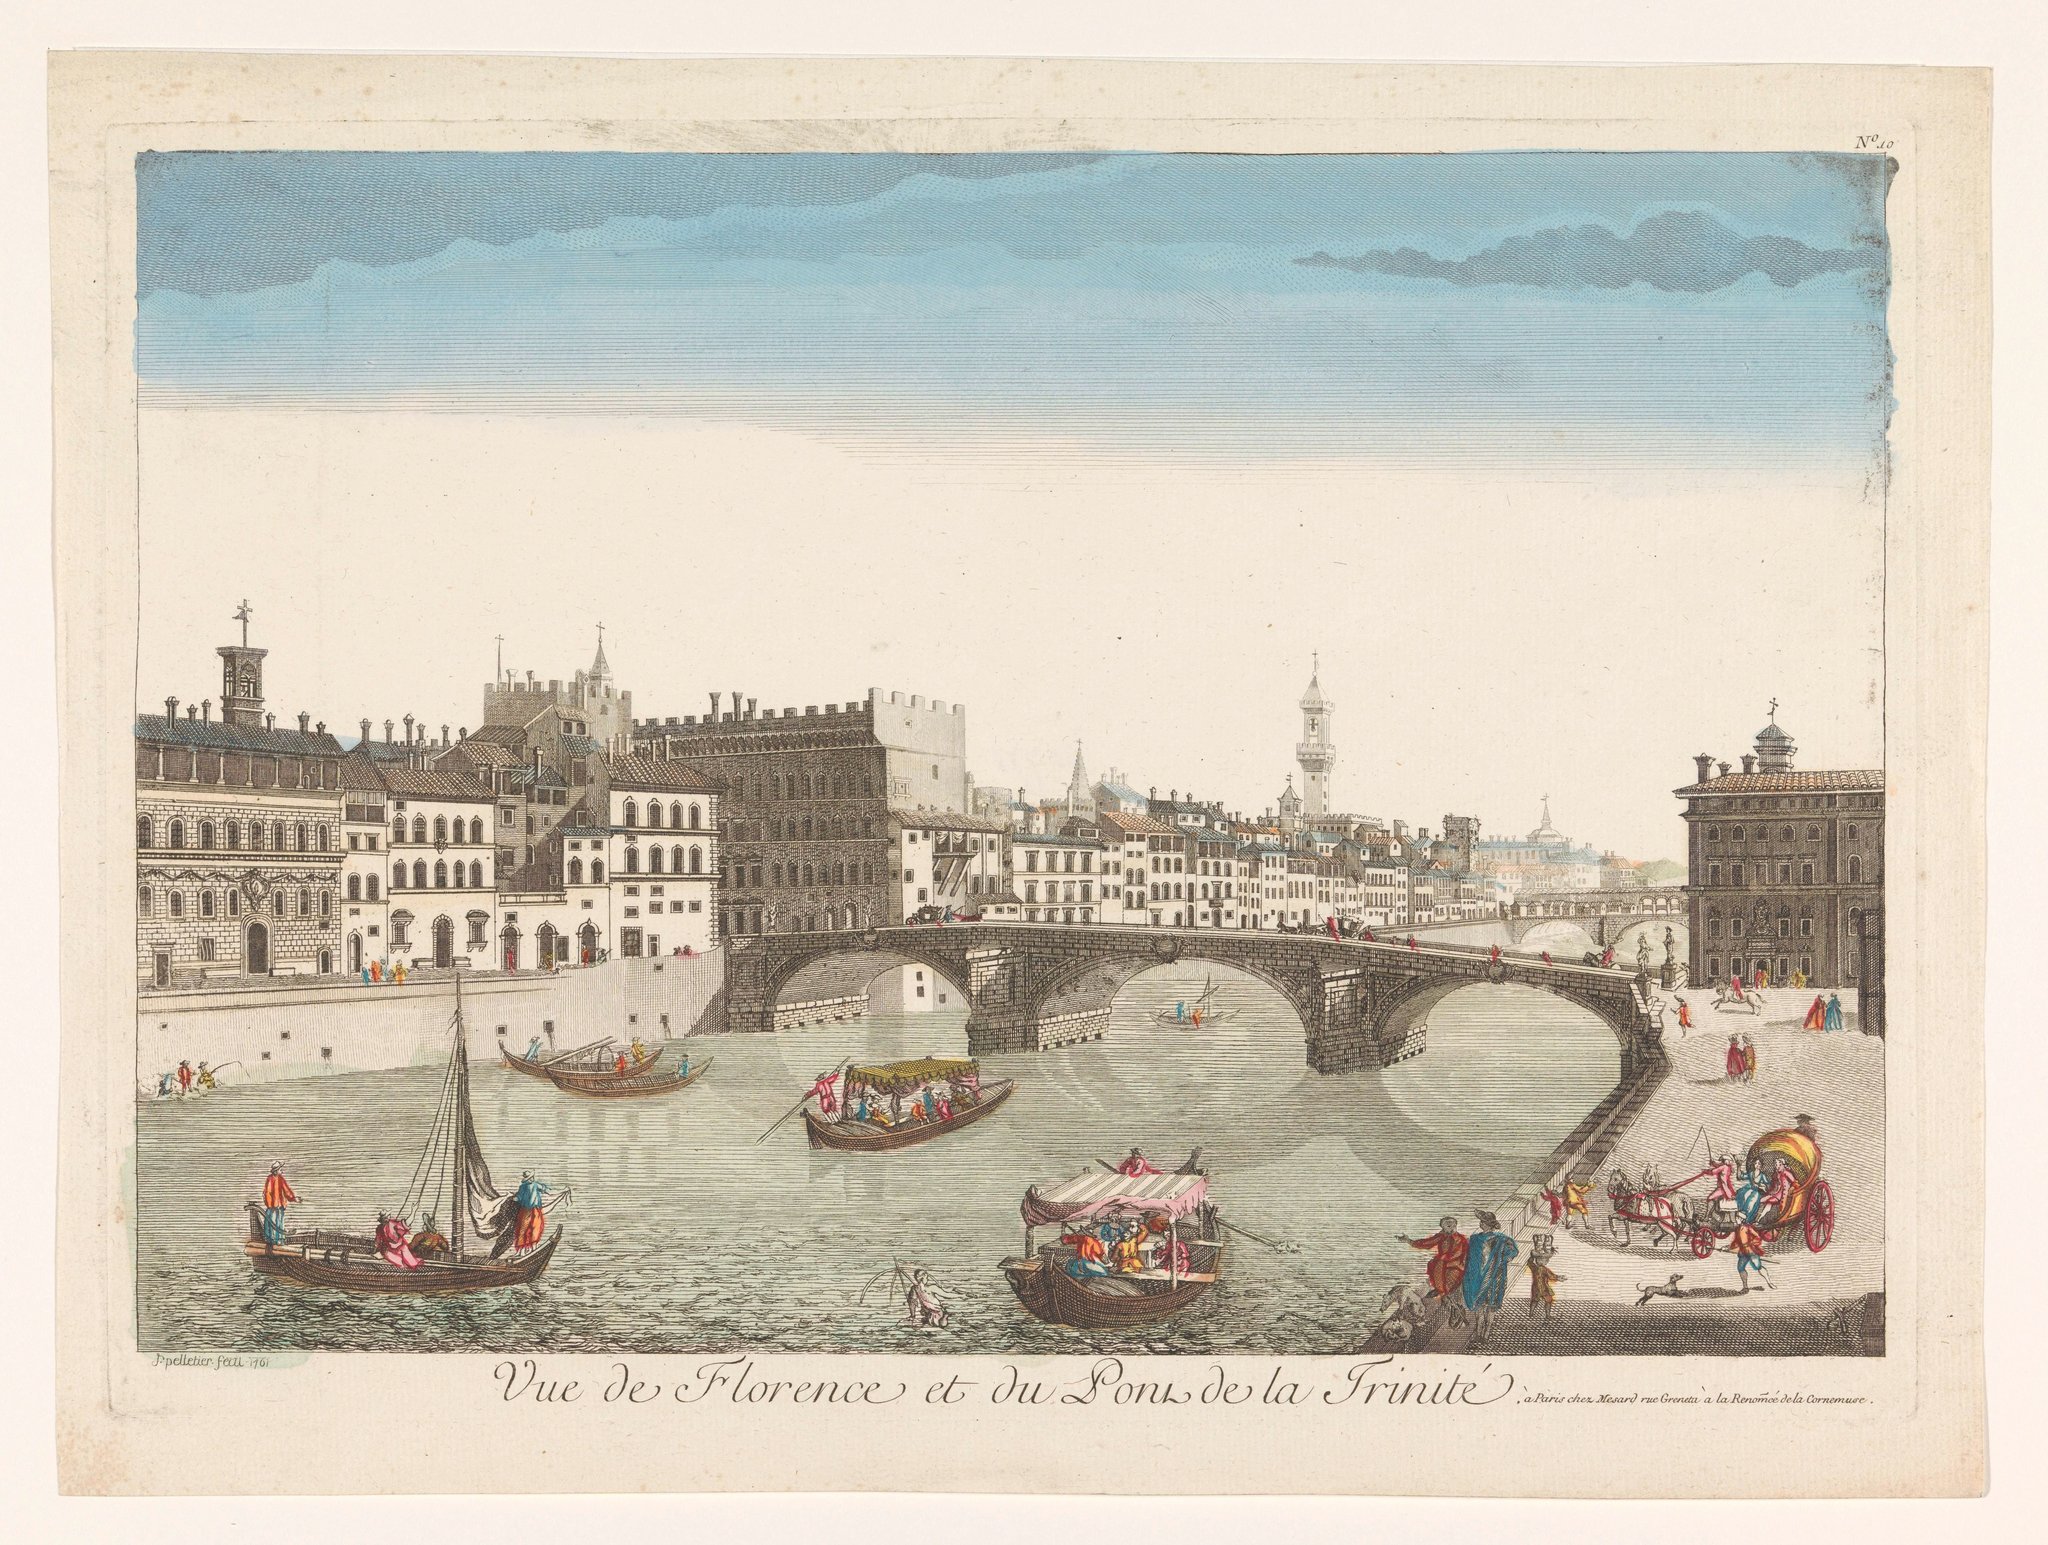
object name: opticaprent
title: Vue de Florence et du Pont de la Trinité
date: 1761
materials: paper, watercolor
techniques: brush, etching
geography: paris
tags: bridge in city across river, canal, etc. (+ city(-scape) with figures, staffage), palace, rowing-boat, canoe, etc.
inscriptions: watermark, collector's mark: Lugt 2233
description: Op de achtergrond de Ponte Vecchio en het Palazzo Vecchio. Genummerd: 10.